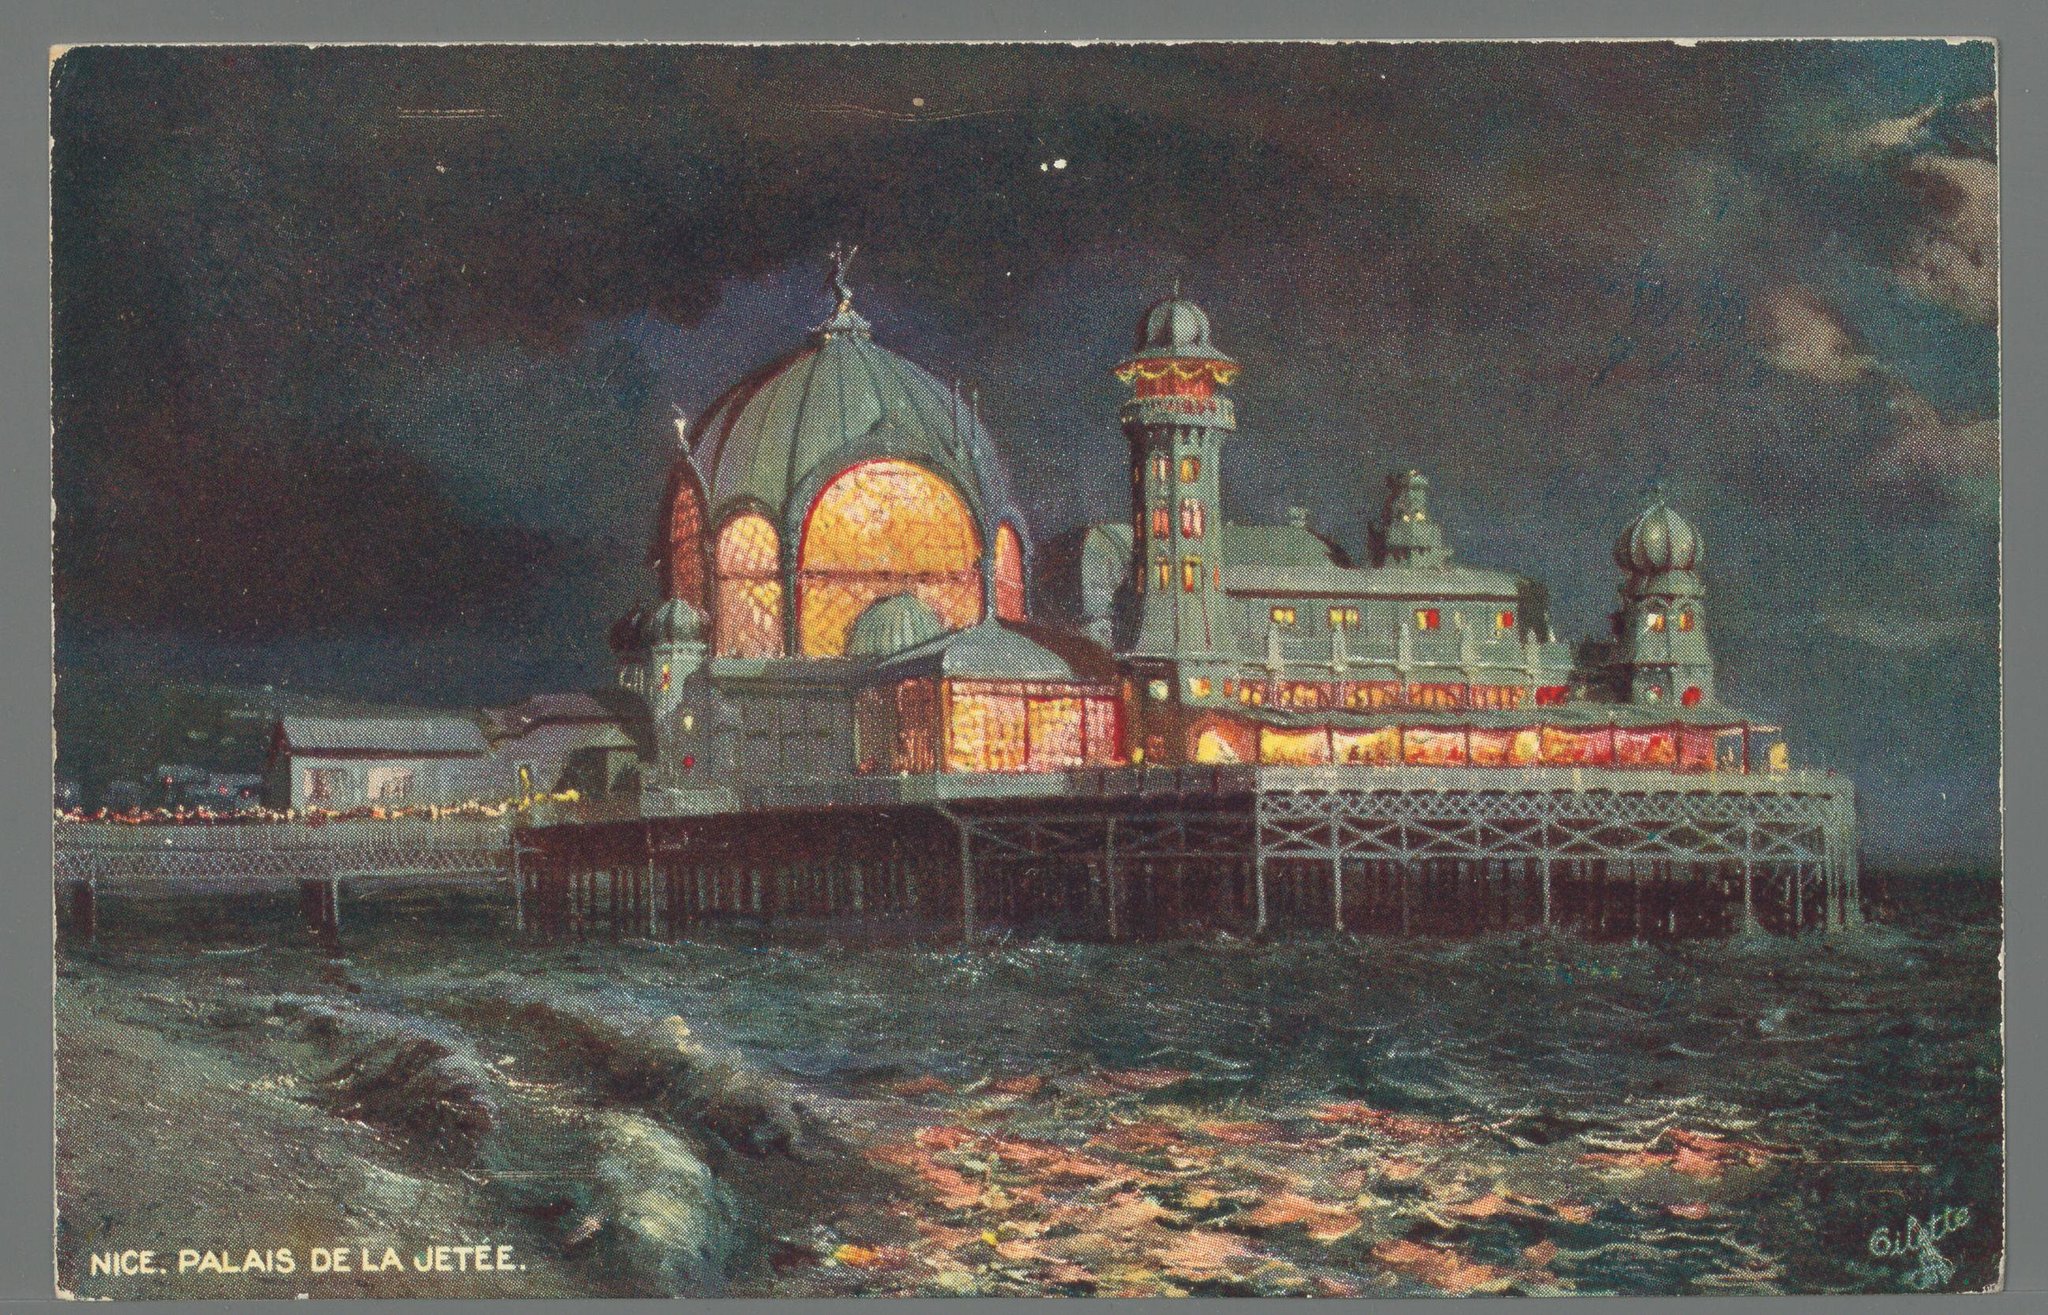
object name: photomechanical print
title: Nice. Palais de la Jetée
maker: Anonymous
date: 1911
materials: cardboard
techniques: writing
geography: paris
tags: palace, sea (seascape), pier, quay, wharf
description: Het serienummer op de kaart is 57. De kaart werd verkocht in een set van 6, genummerd 55-60.